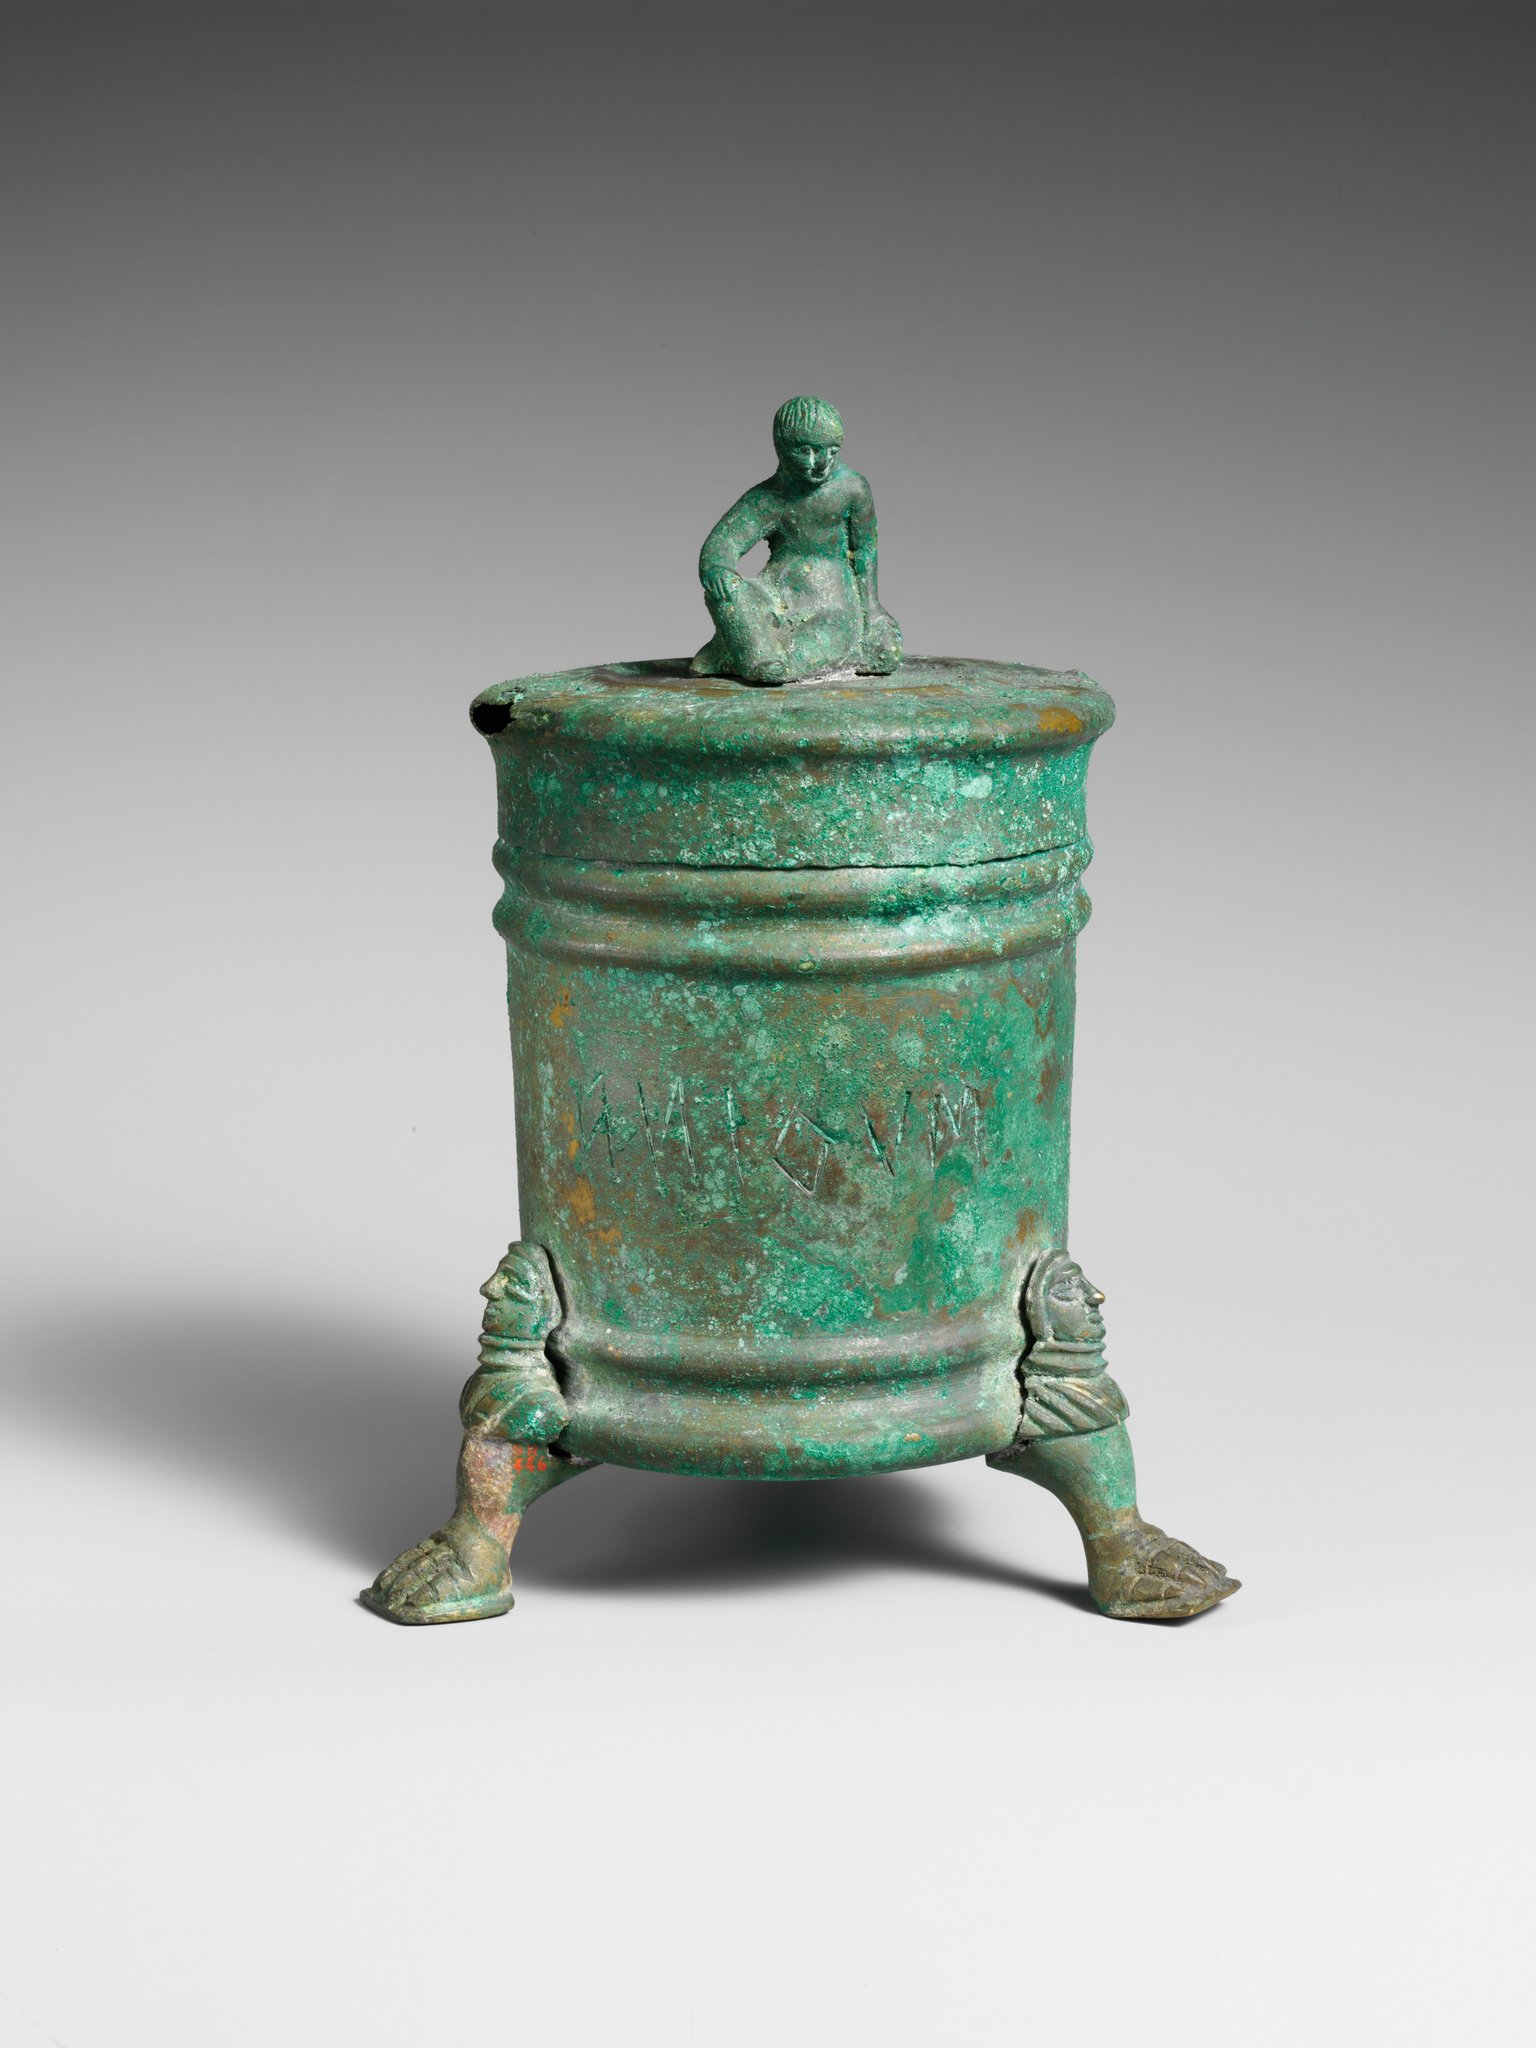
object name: cista with lid, inscribed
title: Bronze cista (toiletries box)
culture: etruscan or praenestine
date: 300-268 BCE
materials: bronze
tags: boys